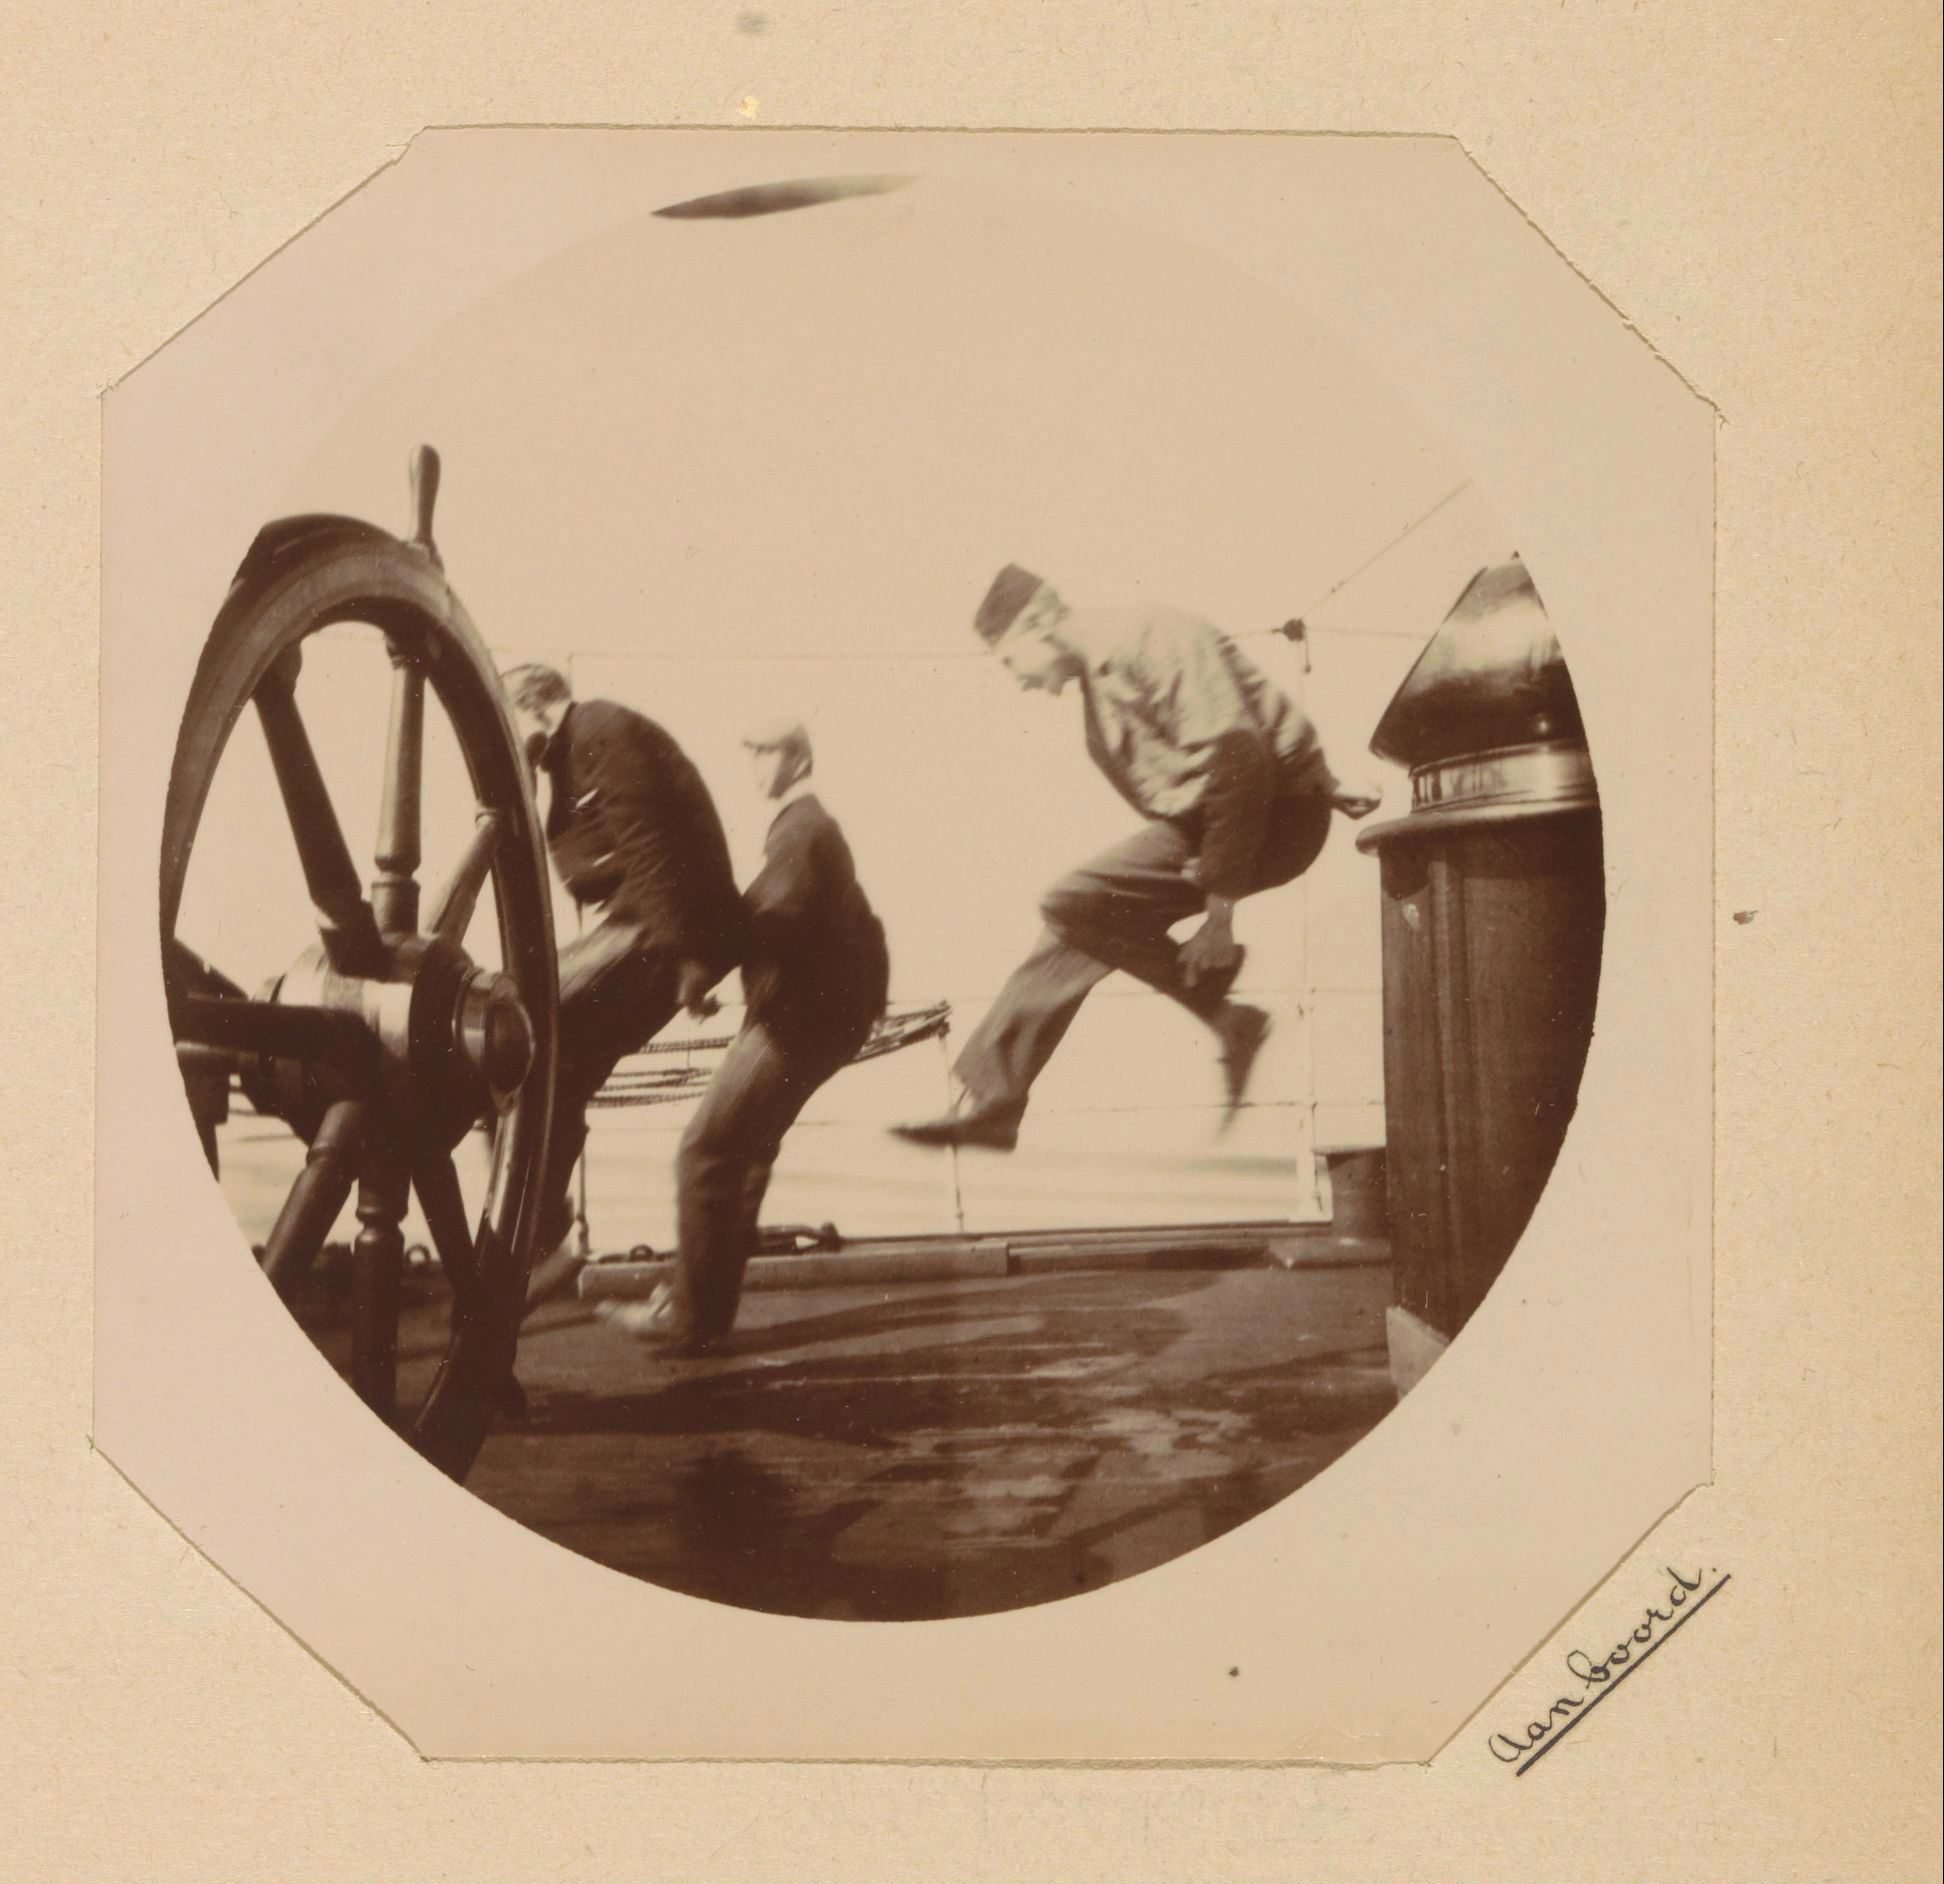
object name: photograph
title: Shots in Amsterdam, Warnemünde, and Warnsborn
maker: willem frederik piek jr.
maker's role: fotograaf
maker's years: 1874-1954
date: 1889-1893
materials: paper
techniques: gelatin silver print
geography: baltic sea region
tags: jumping games, ships (in general)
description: The photograph of Herengracht was the key for identifying the album as belonging to the Pieks. It was taken from the house at number 258, where the family lived. We see the couple and their son with his classmates on an excursion to the Oostzee. The street photograph is an impression of German kaiser Wilhelm II’s visit to Amsterdam. The round, 9 centimetre photographs were taken with the improved Kodak No. 2.